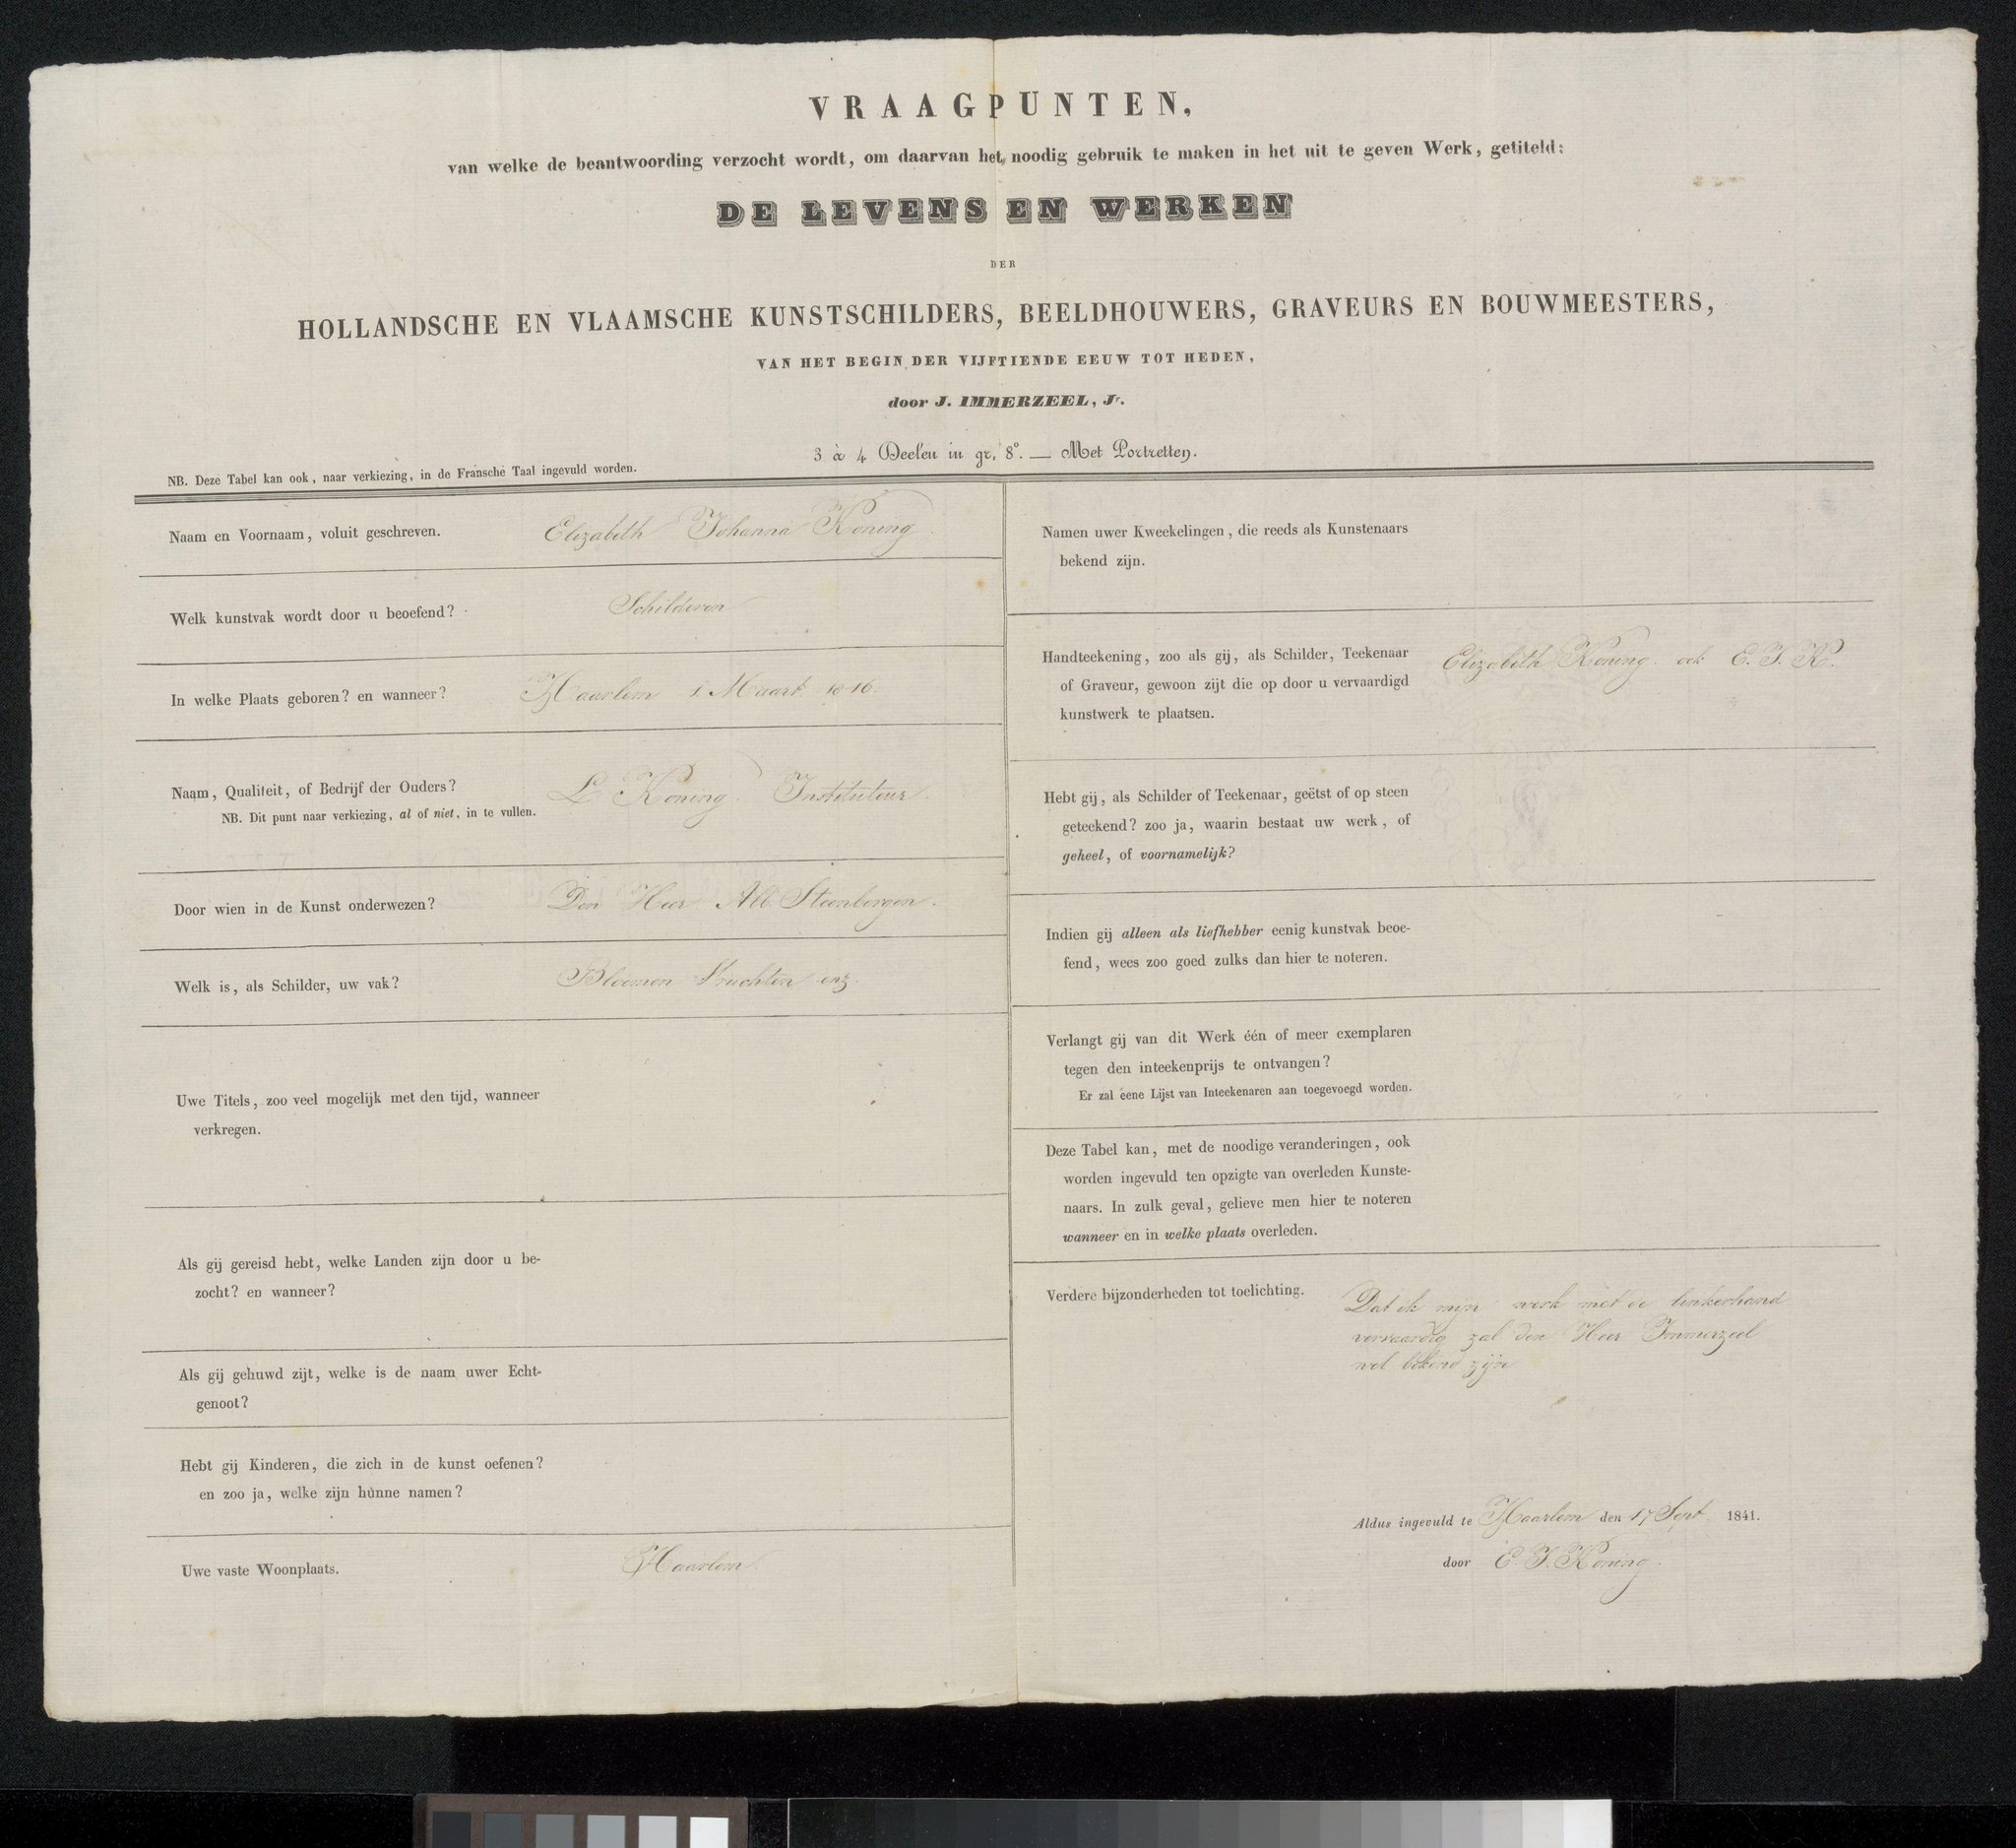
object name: manuscript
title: Enquêteformulier ingevuld door Elisabeth Johanna Koning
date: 1841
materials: ink, paper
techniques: pen, printing, writing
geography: haarlem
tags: rotterdam, print maker, elisabeth johanna koning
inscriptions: inscription: ‘Vraagpunten,/ van welke de beantwoording verzocht wordt, om daarvan het noodig gebruik te maken in het uit te geven Werk, getiteld: De levens en werken/ der Hollandsche en Vlaamsche kunstschilders, beeldhouwers,/ graveurs en bouwmeesters, van het begin der vijftiende eeuw tot heden/ door J. Immerzeel, Jr.’, watermark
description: Opgenomen in: Immerzeel, J. Jr., De levens en werken der Hollandsche en Vlaamsche kunstschilders, beeldhouwers, graveurs en bouwmeesters, van het begin der vijftiende eeuw tot heden, Amsterdam: J.C. van Kesteren, 1842-1843.